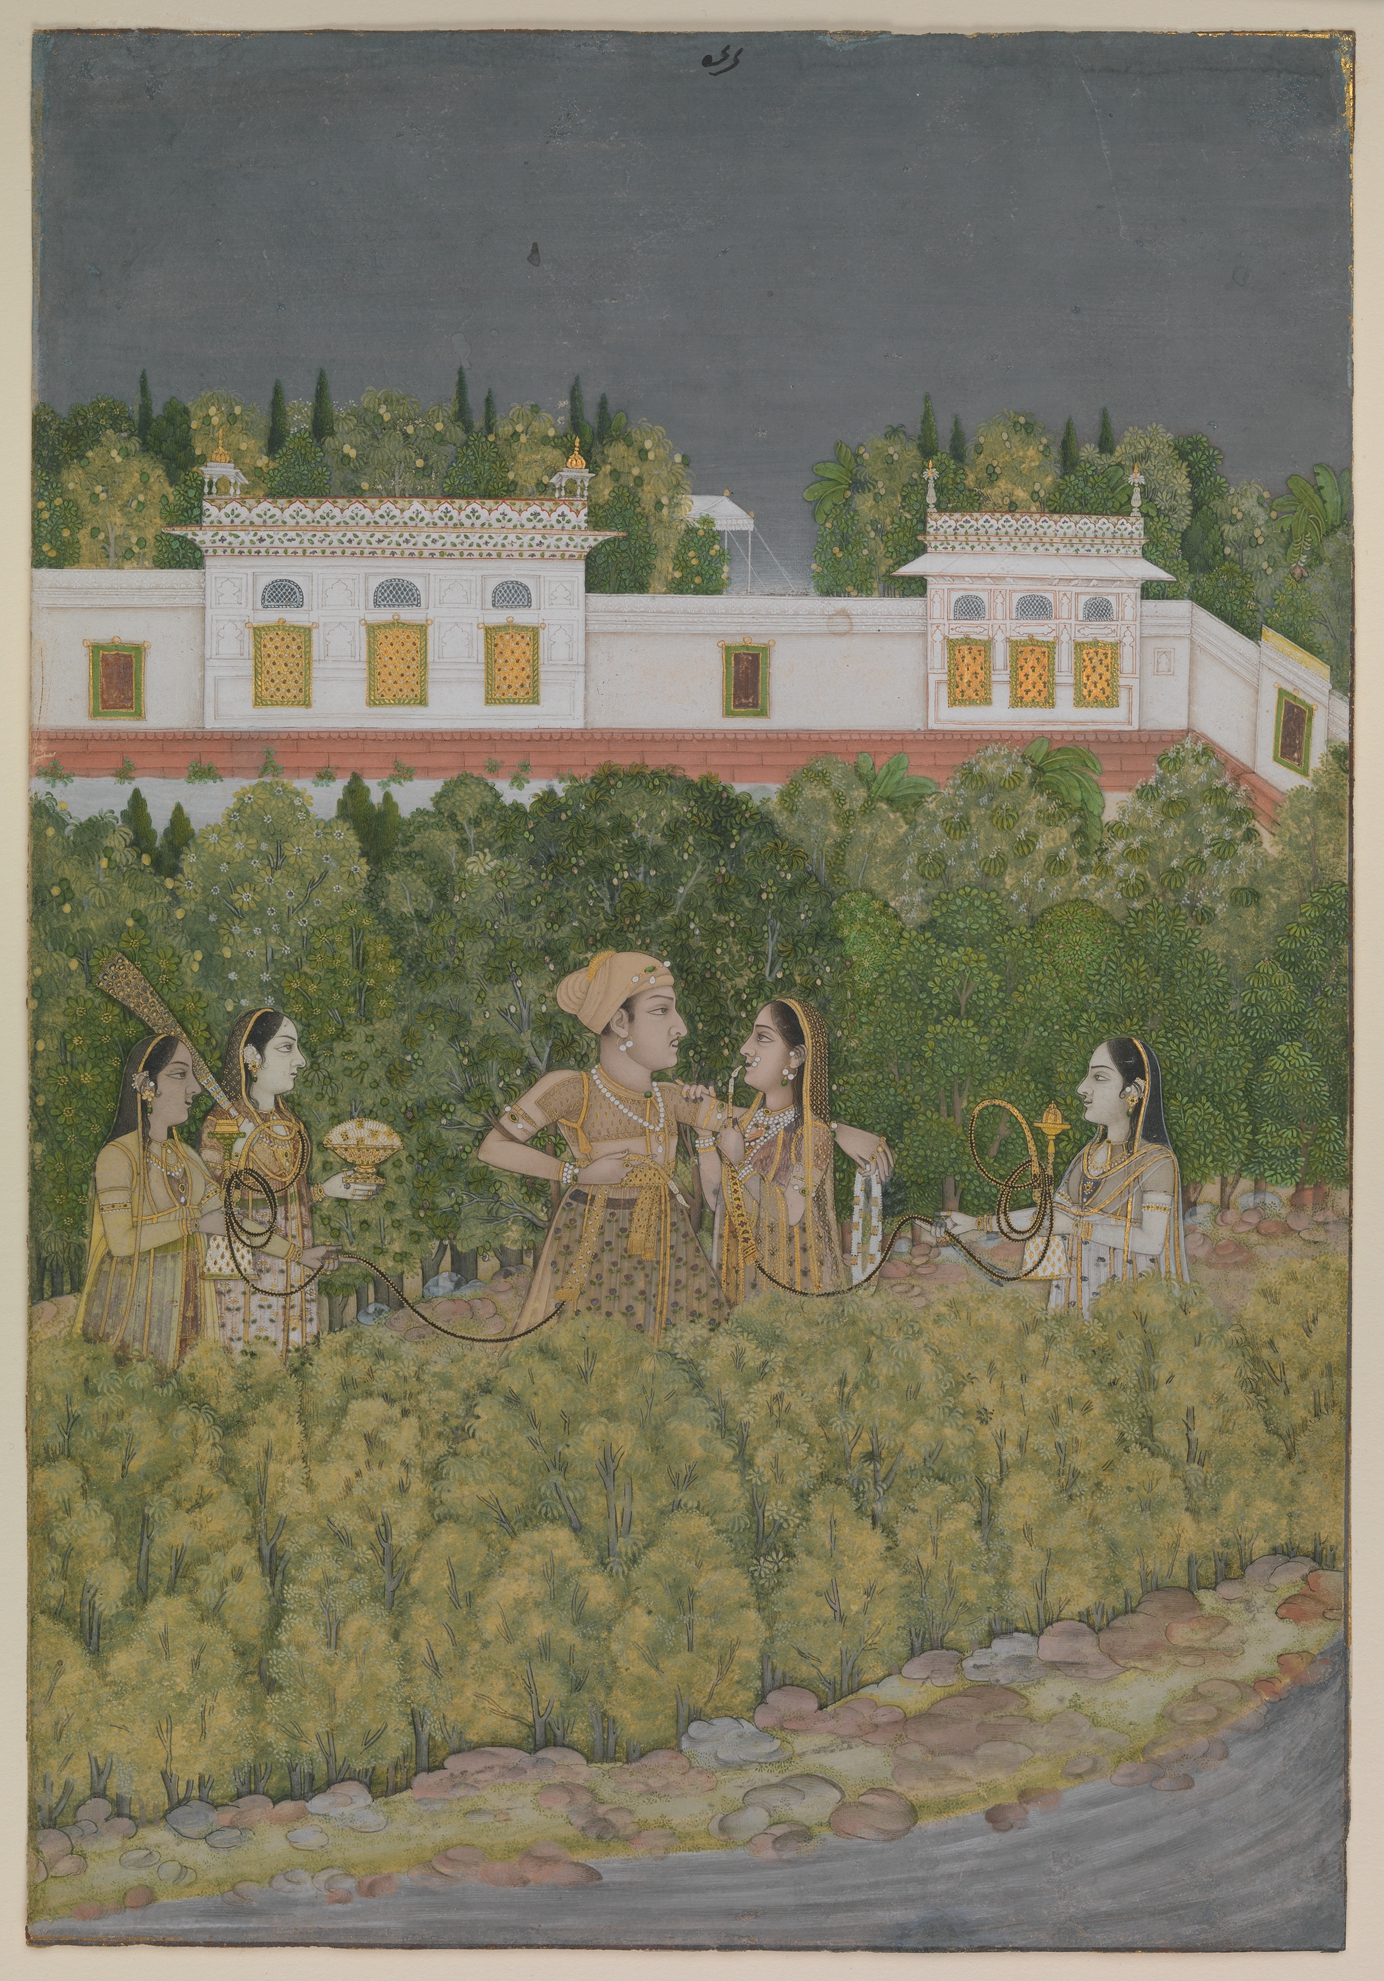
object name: illustrated single work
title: Prince and Ladies in a Garden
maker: nidha mal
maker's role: artist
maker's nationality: indian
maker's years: 1710-1799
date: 1734-1766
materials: gold, ink, paper, watercolor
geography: india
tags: gardens,princes,couples,men,women,smoking,hookah